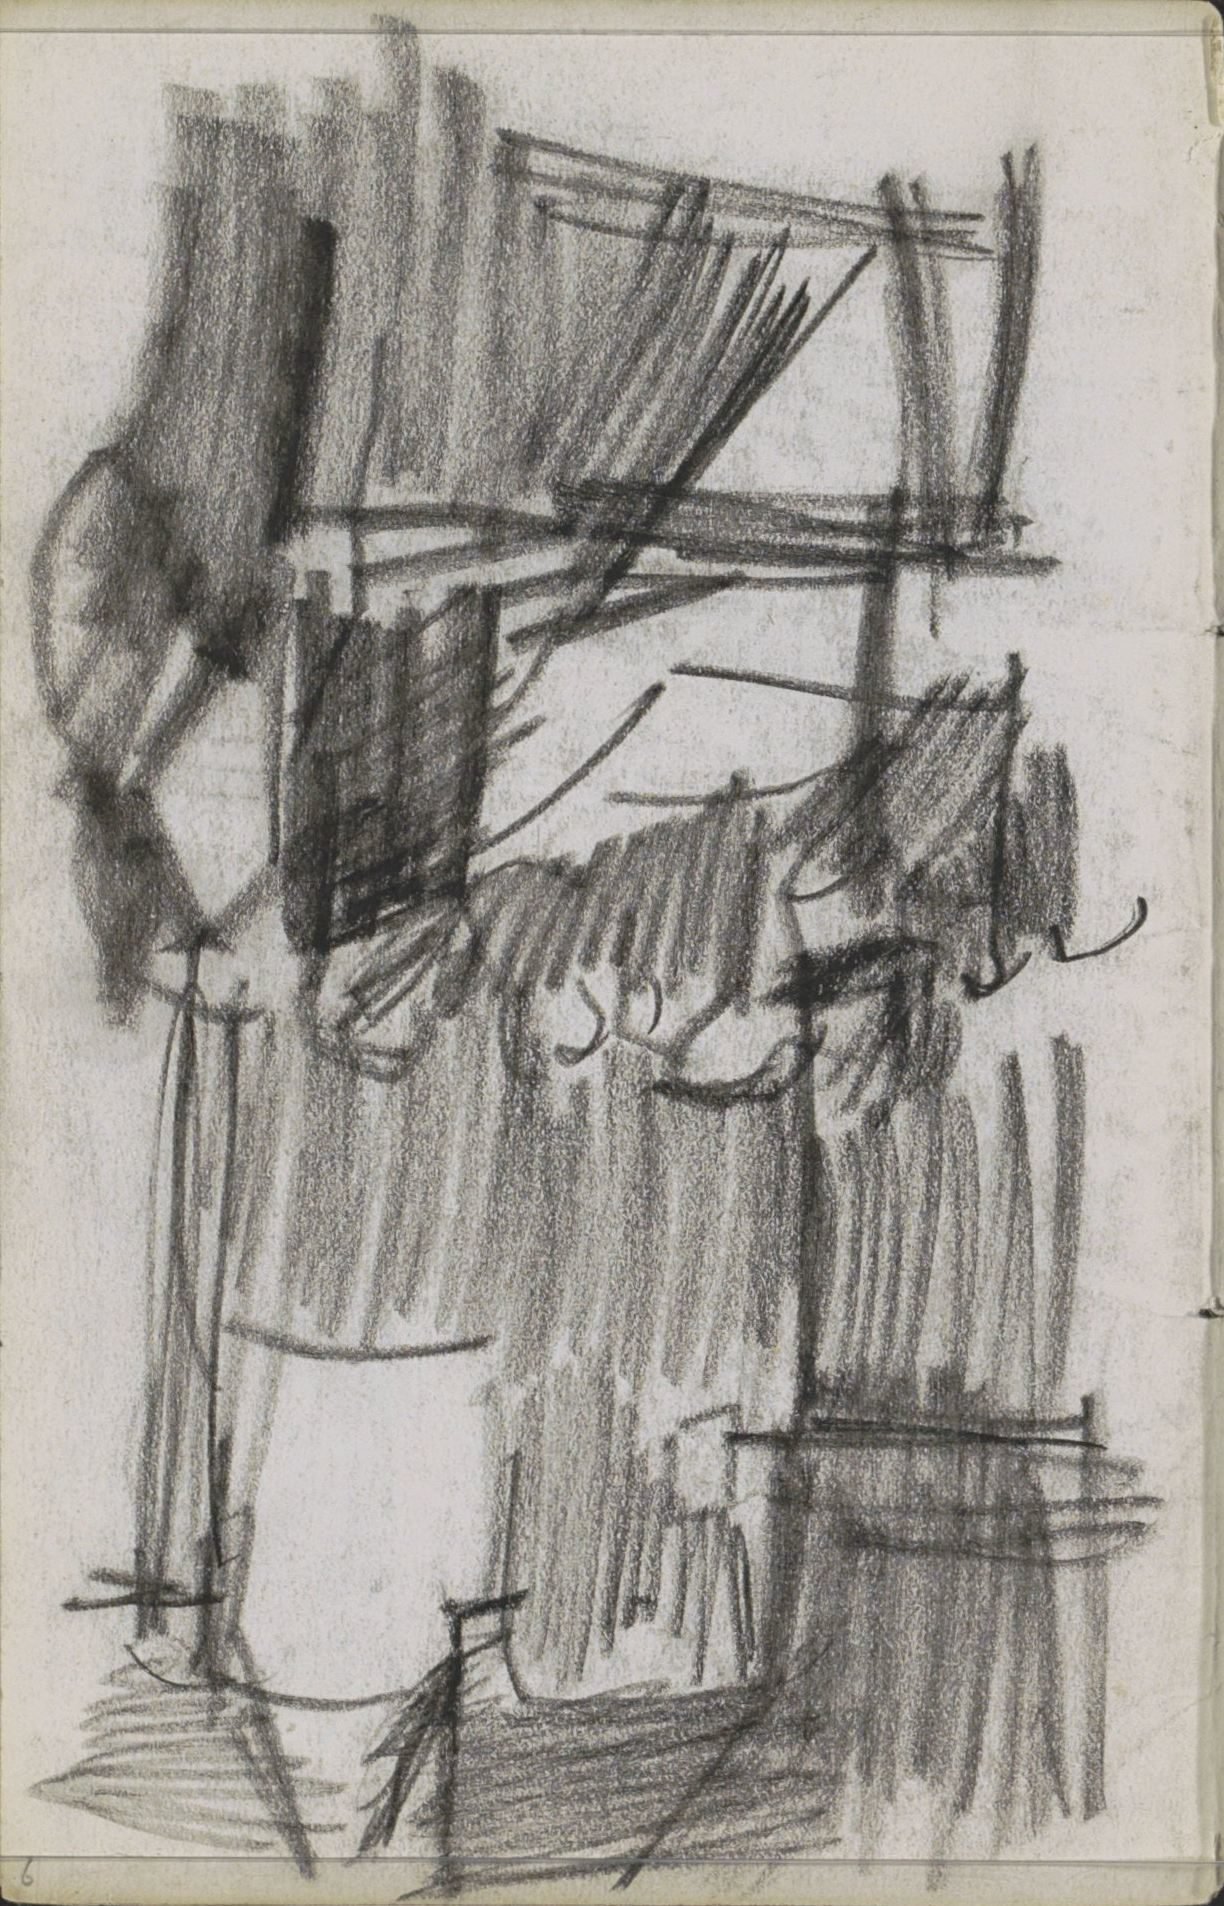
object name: sketchbook leaf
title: Figuren aan een tafel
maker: isaac israels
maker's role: draughtsman, painter, print maker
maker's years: 1865-1934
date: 1875-1934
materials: chalk, paper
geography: amsterdam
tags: sitting figure, table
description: Pagina 6 uit schetsboek XXIX met 44 pagina's.